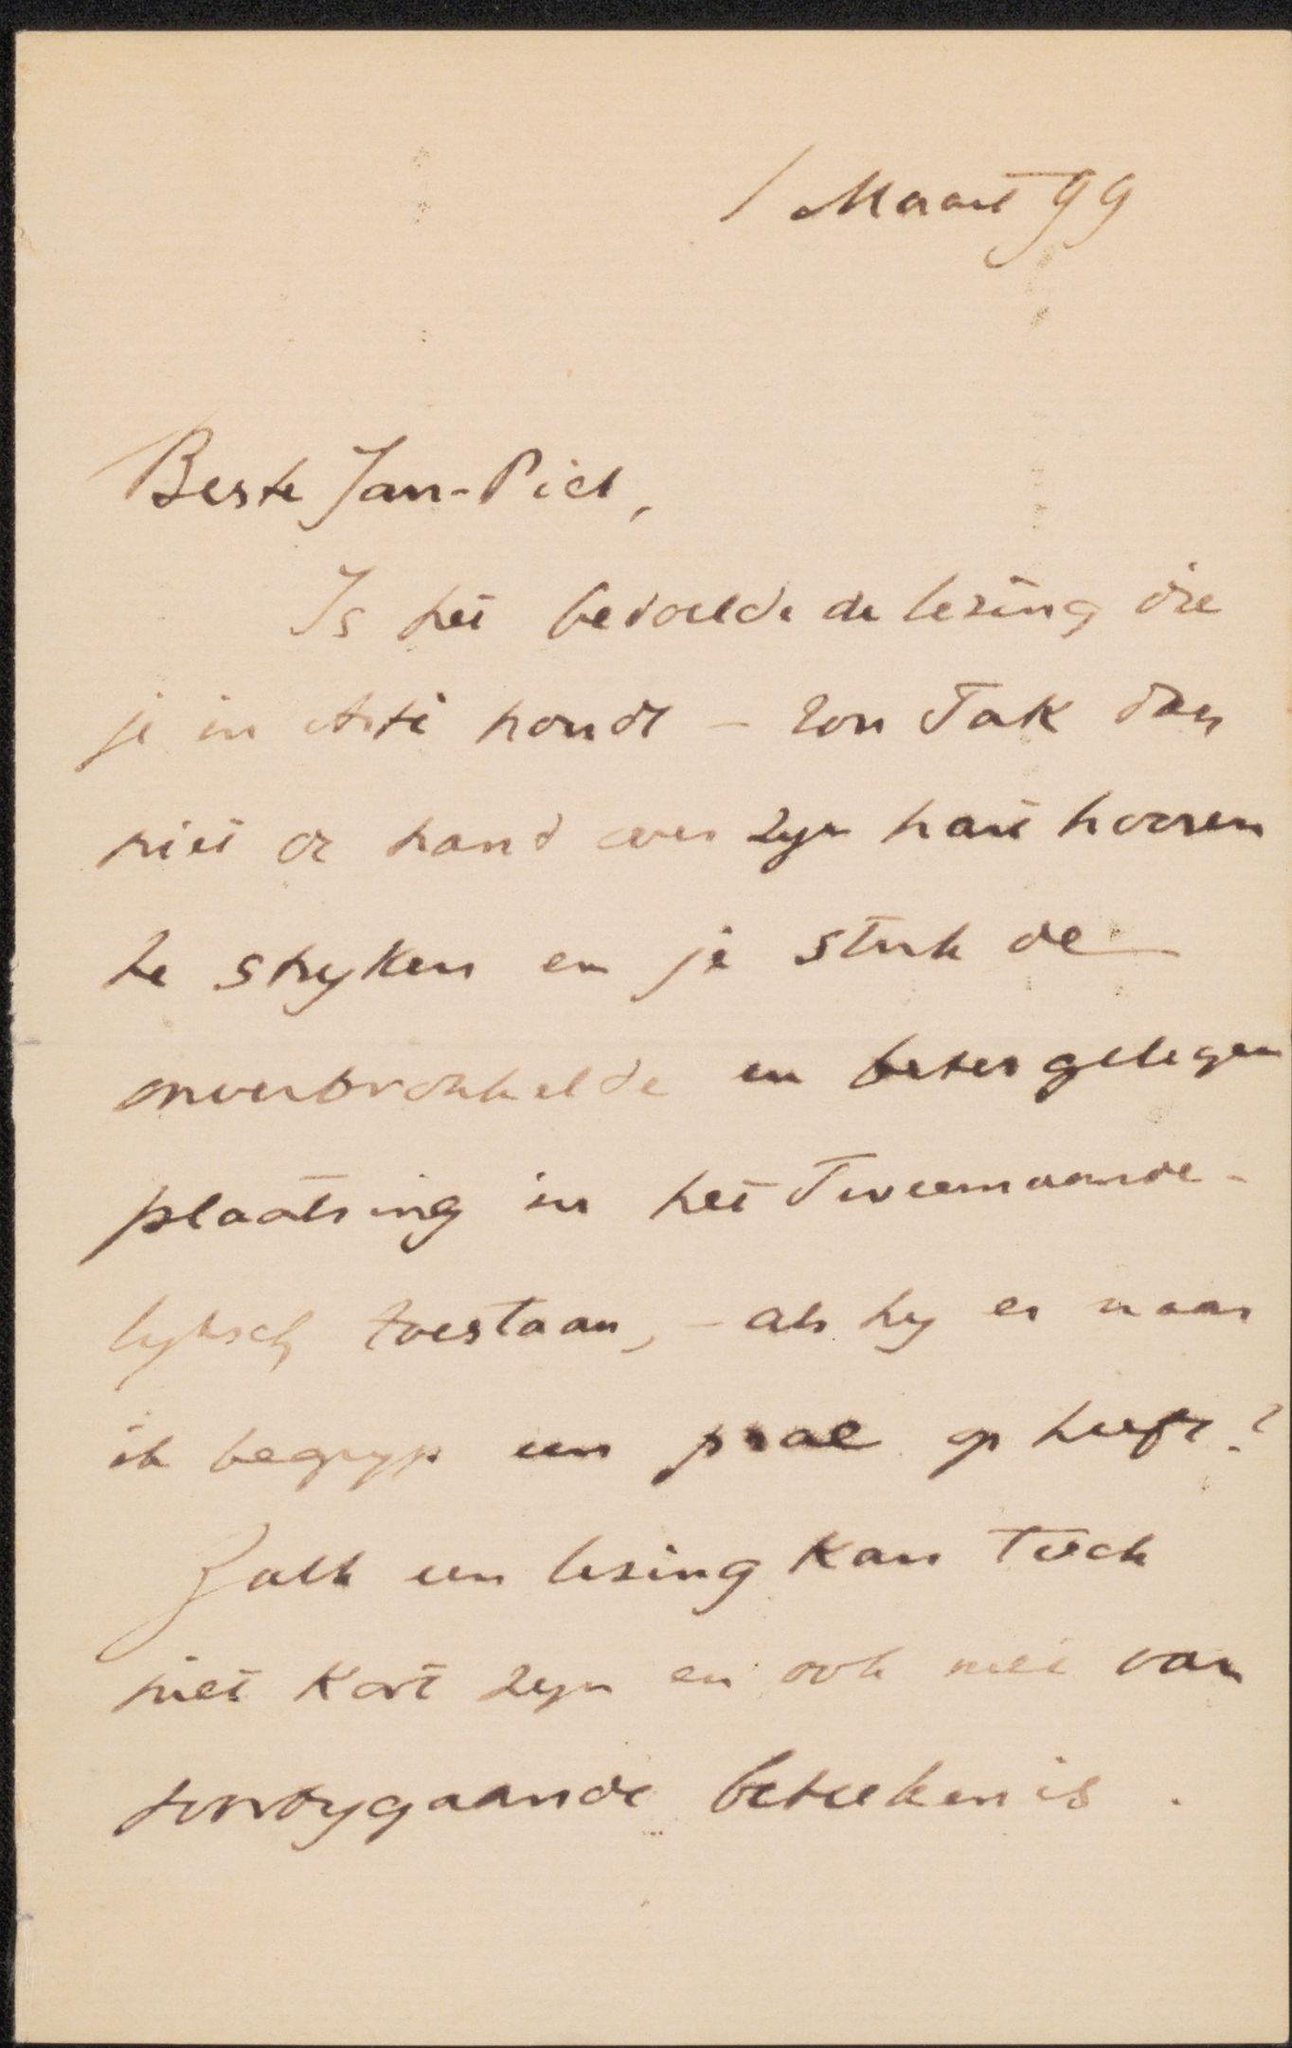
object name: letter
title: Brief aan Jan Veth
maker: albert verwey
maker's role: criticus, dichter, essayist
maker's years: 1865-1937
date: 1899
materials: ink, paper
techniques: pen, writing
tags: painter, draughtsman, designer, jan veth, middelburg, politician, pieter lodewijk tak, deventer, gerlof van vloten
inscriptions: collector's mark: ‘RPK’